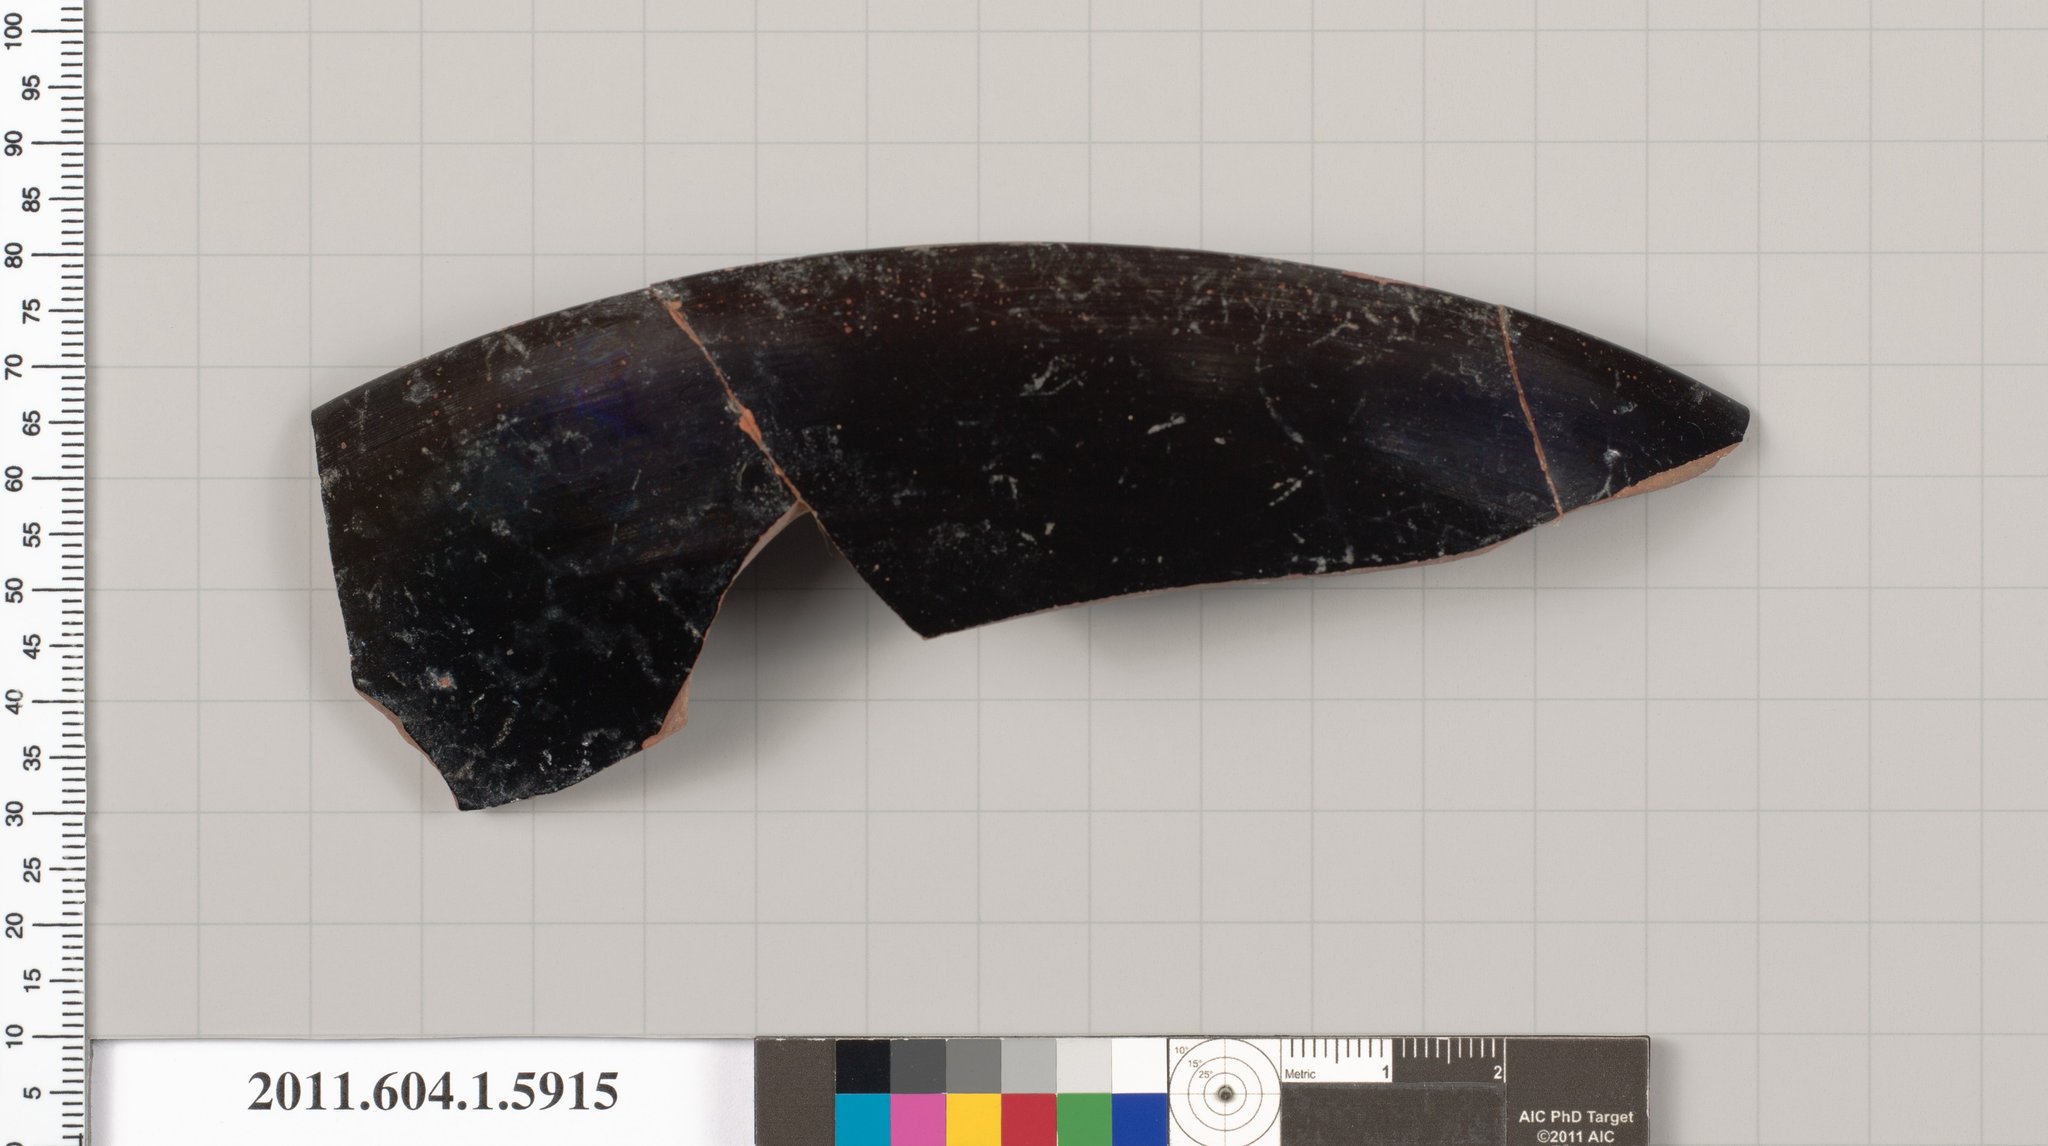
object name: kylix fragment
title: Terracotta rim fragment of a kylix (drinking cup)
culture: greek, attic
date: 520-510 BCE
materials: terracotta